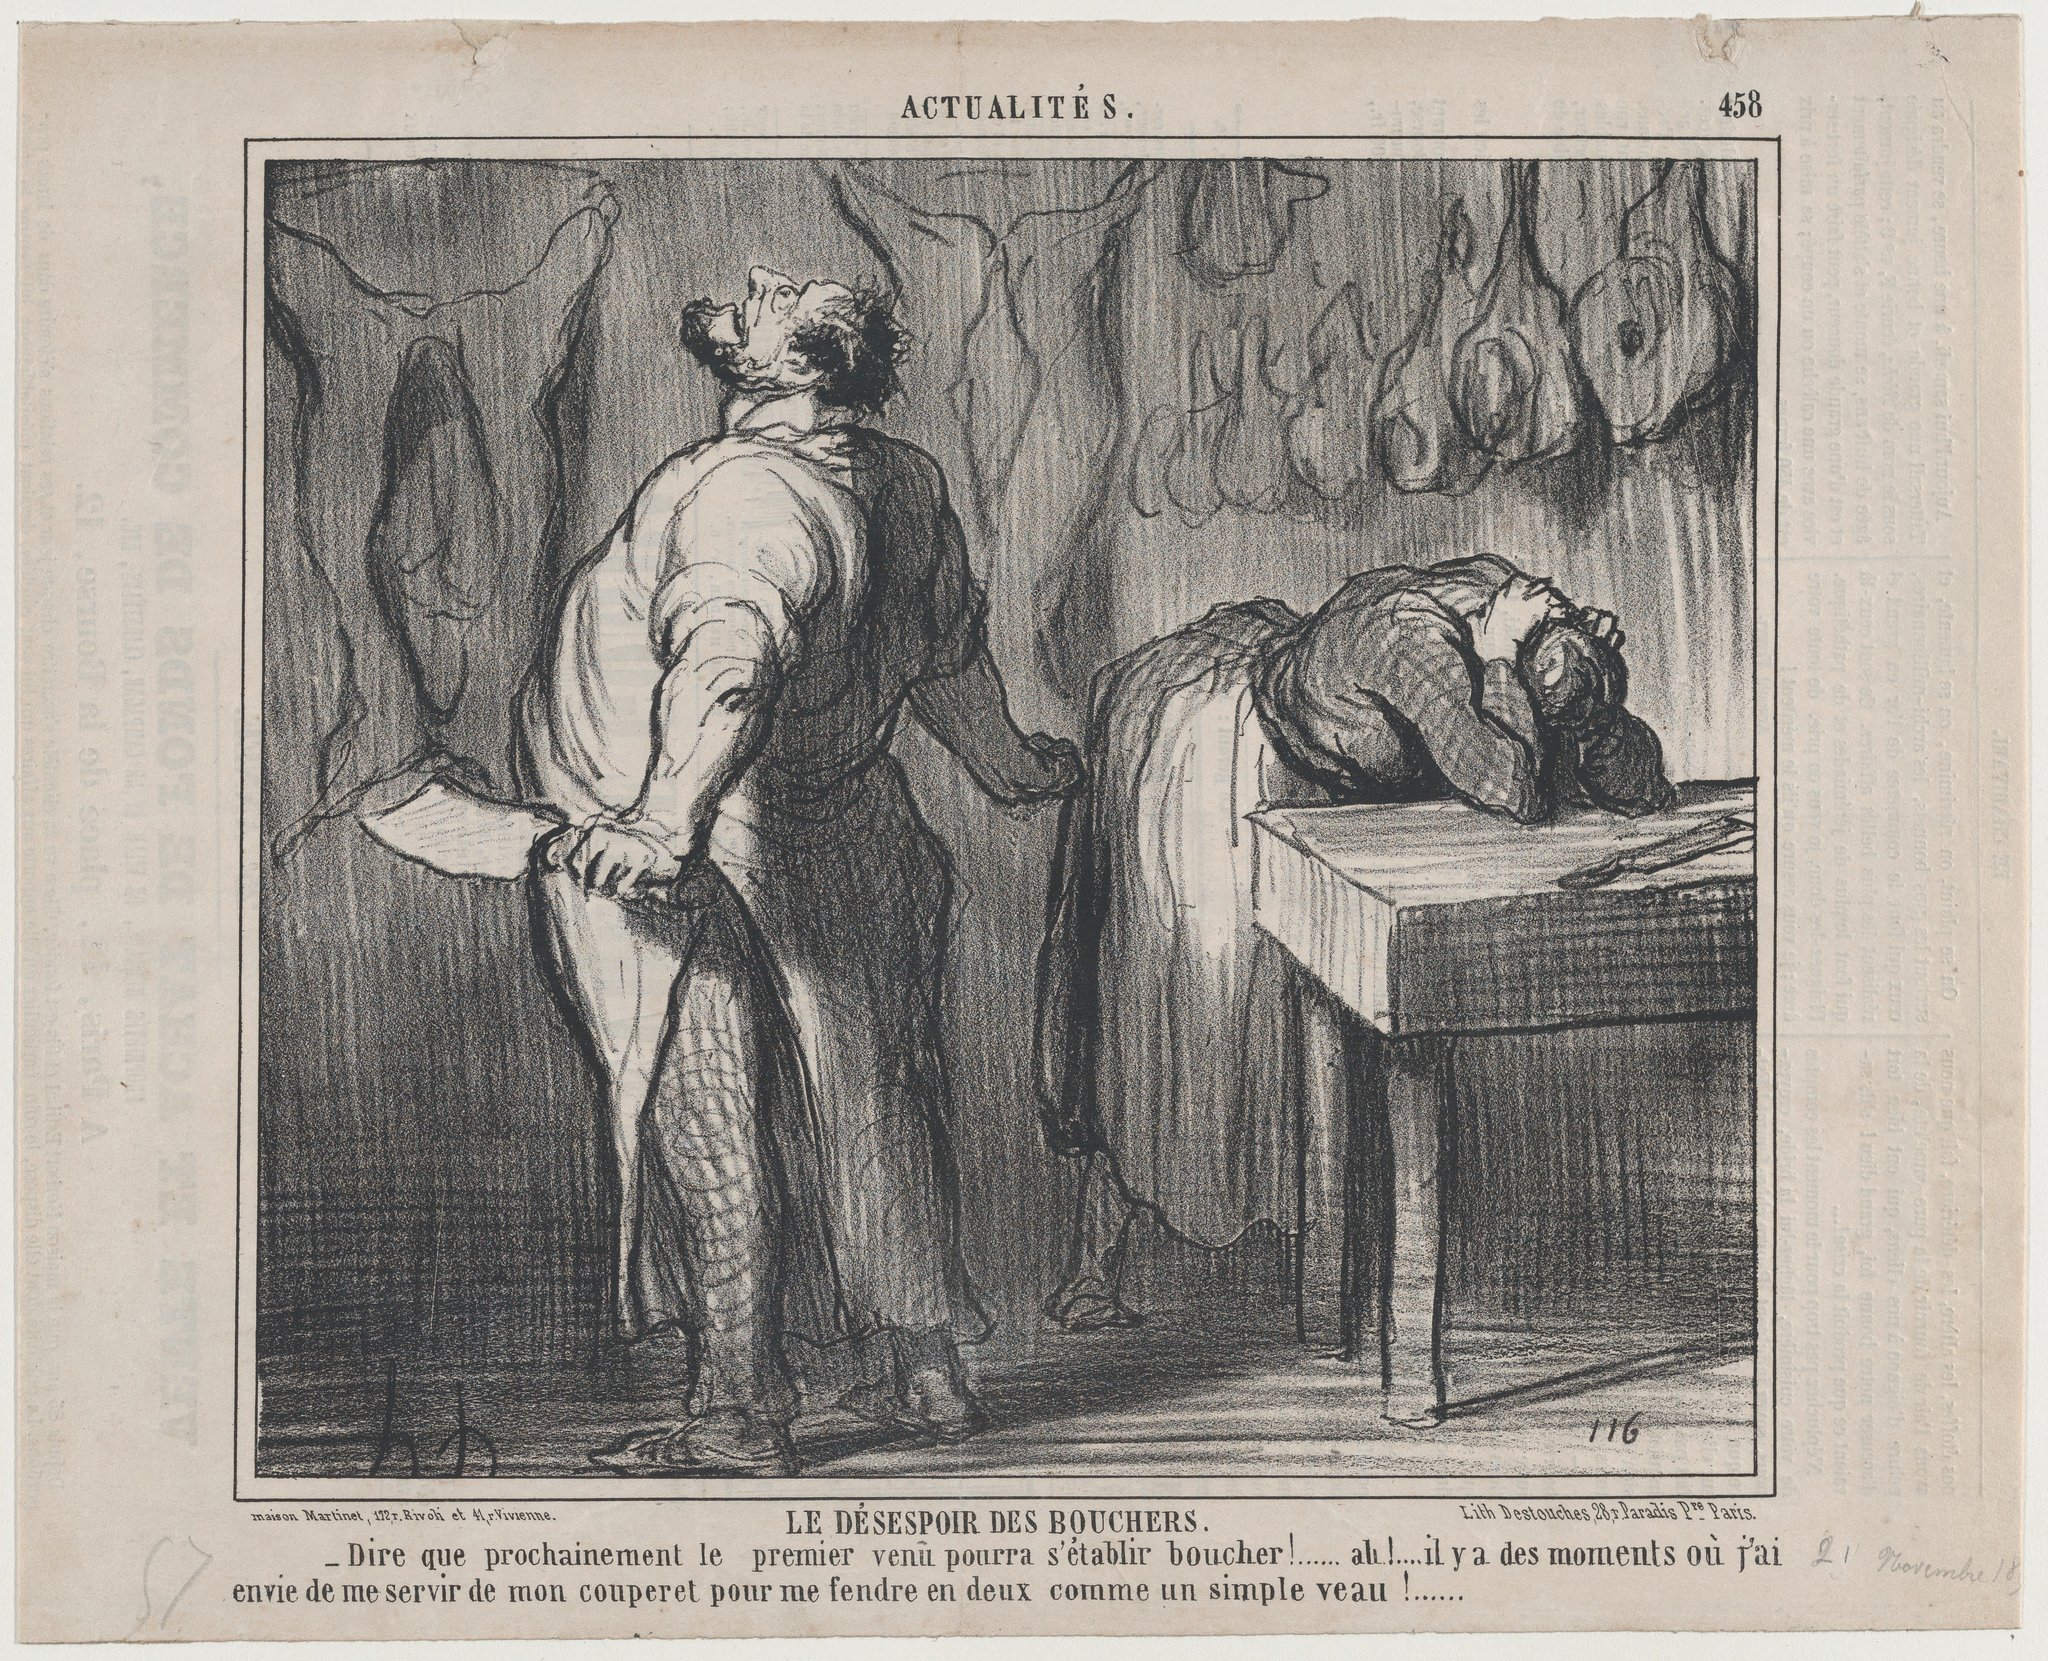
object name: print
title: Le Désespoir des Bouchers, from Actualités, published in Le Charivari, November 21, 1857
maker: honoré daumier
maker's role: artist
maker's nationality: french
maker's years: 1808-1879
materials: paper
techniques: lithograph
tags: men,women